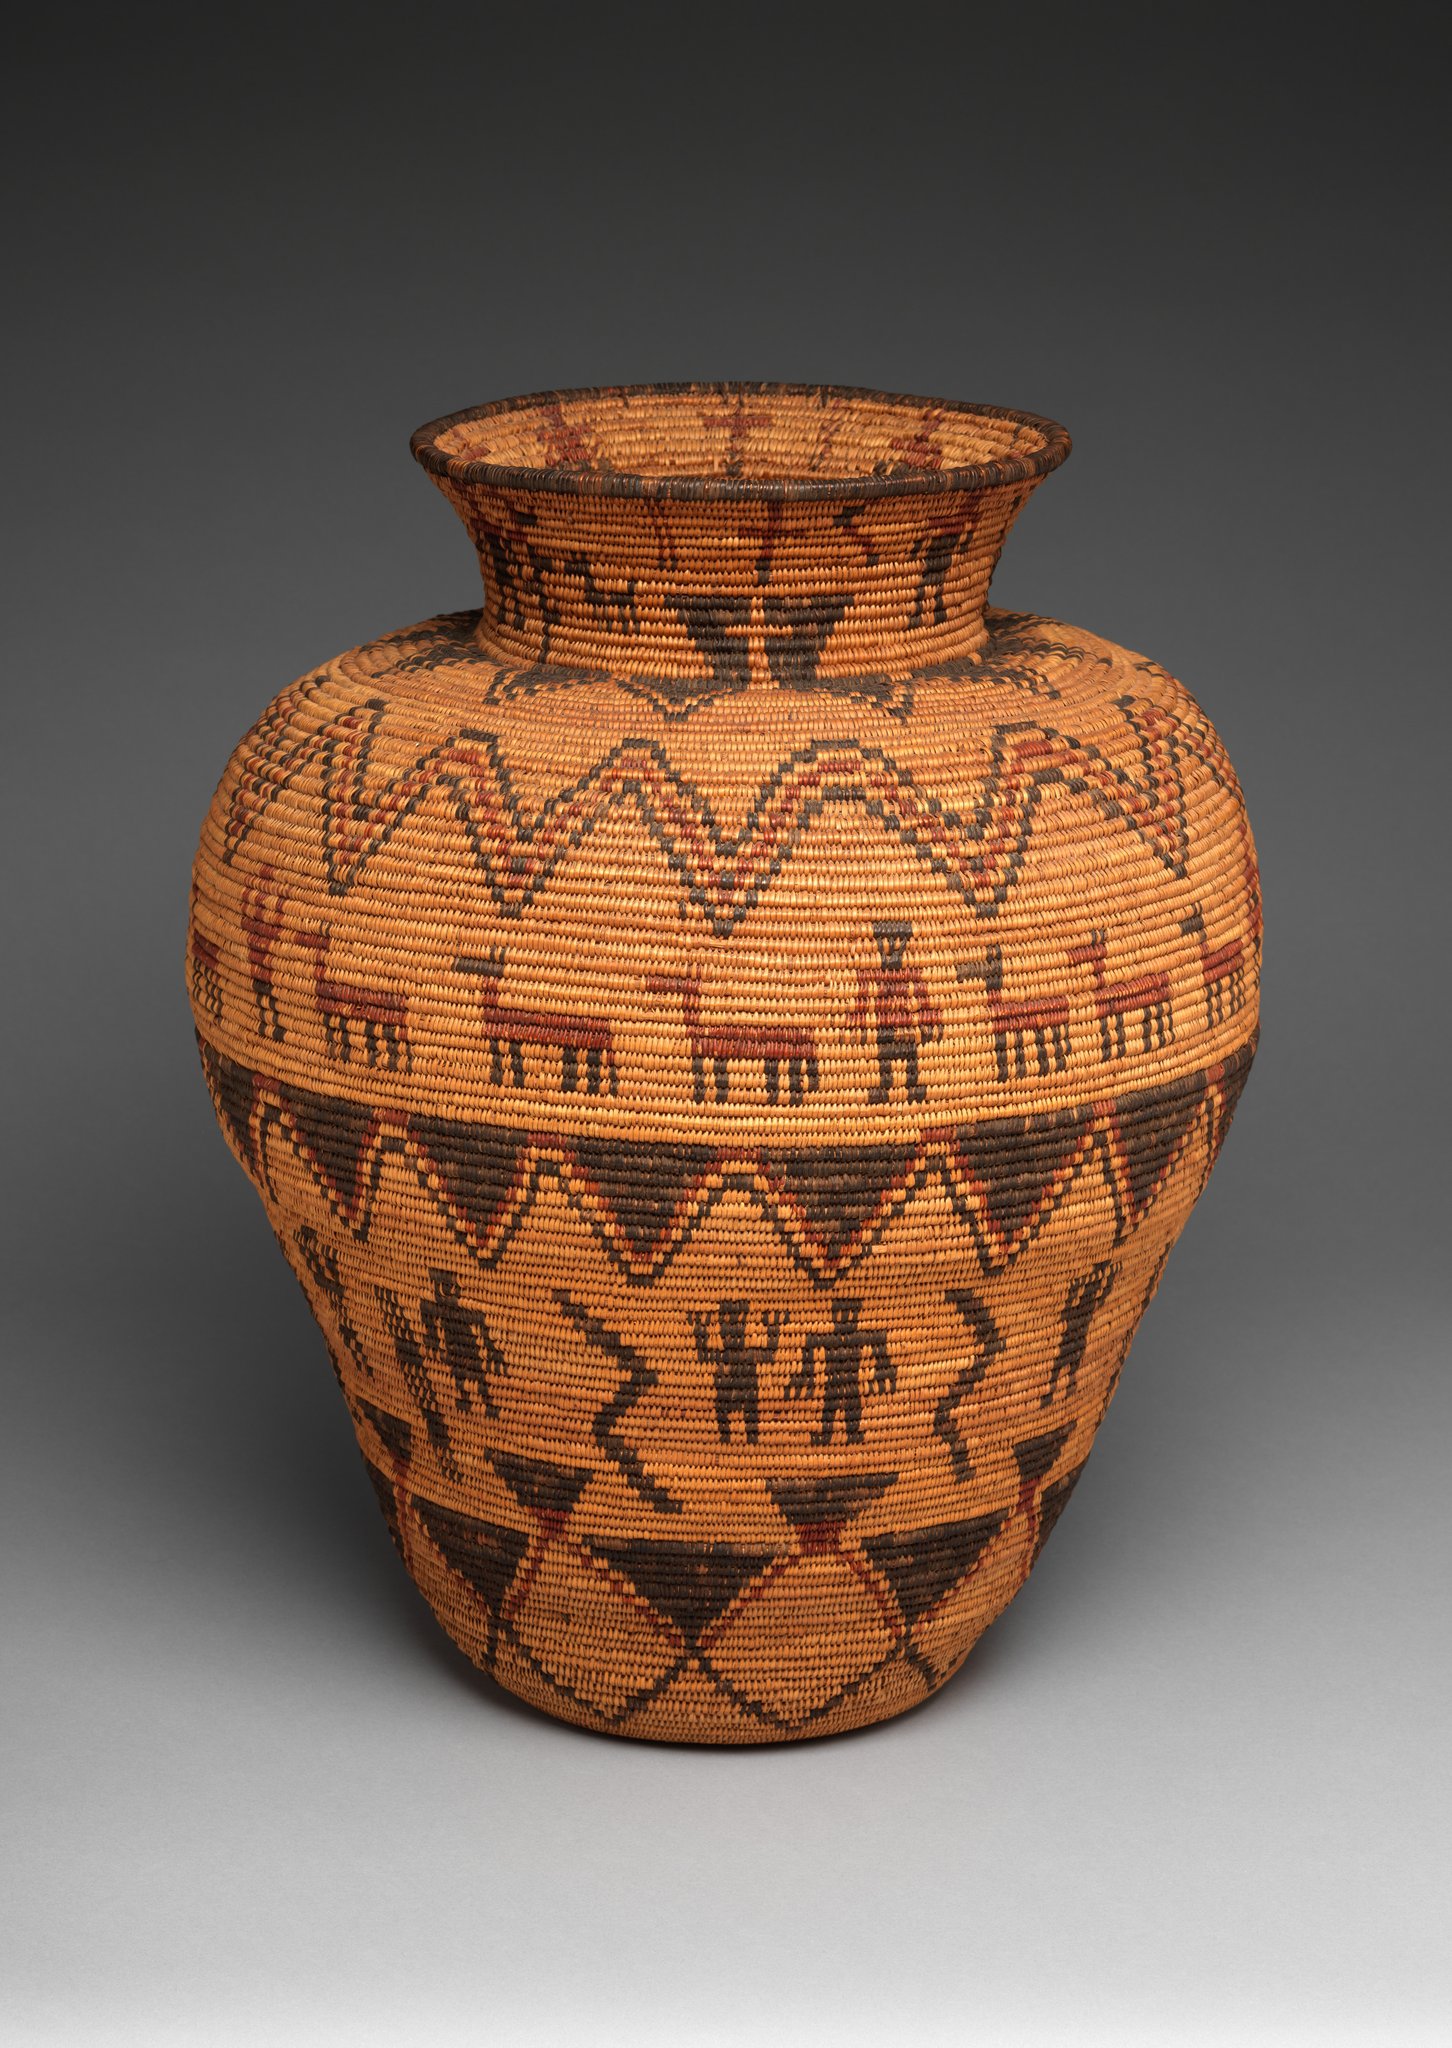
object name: storage basket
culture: apache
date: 1890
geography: united states